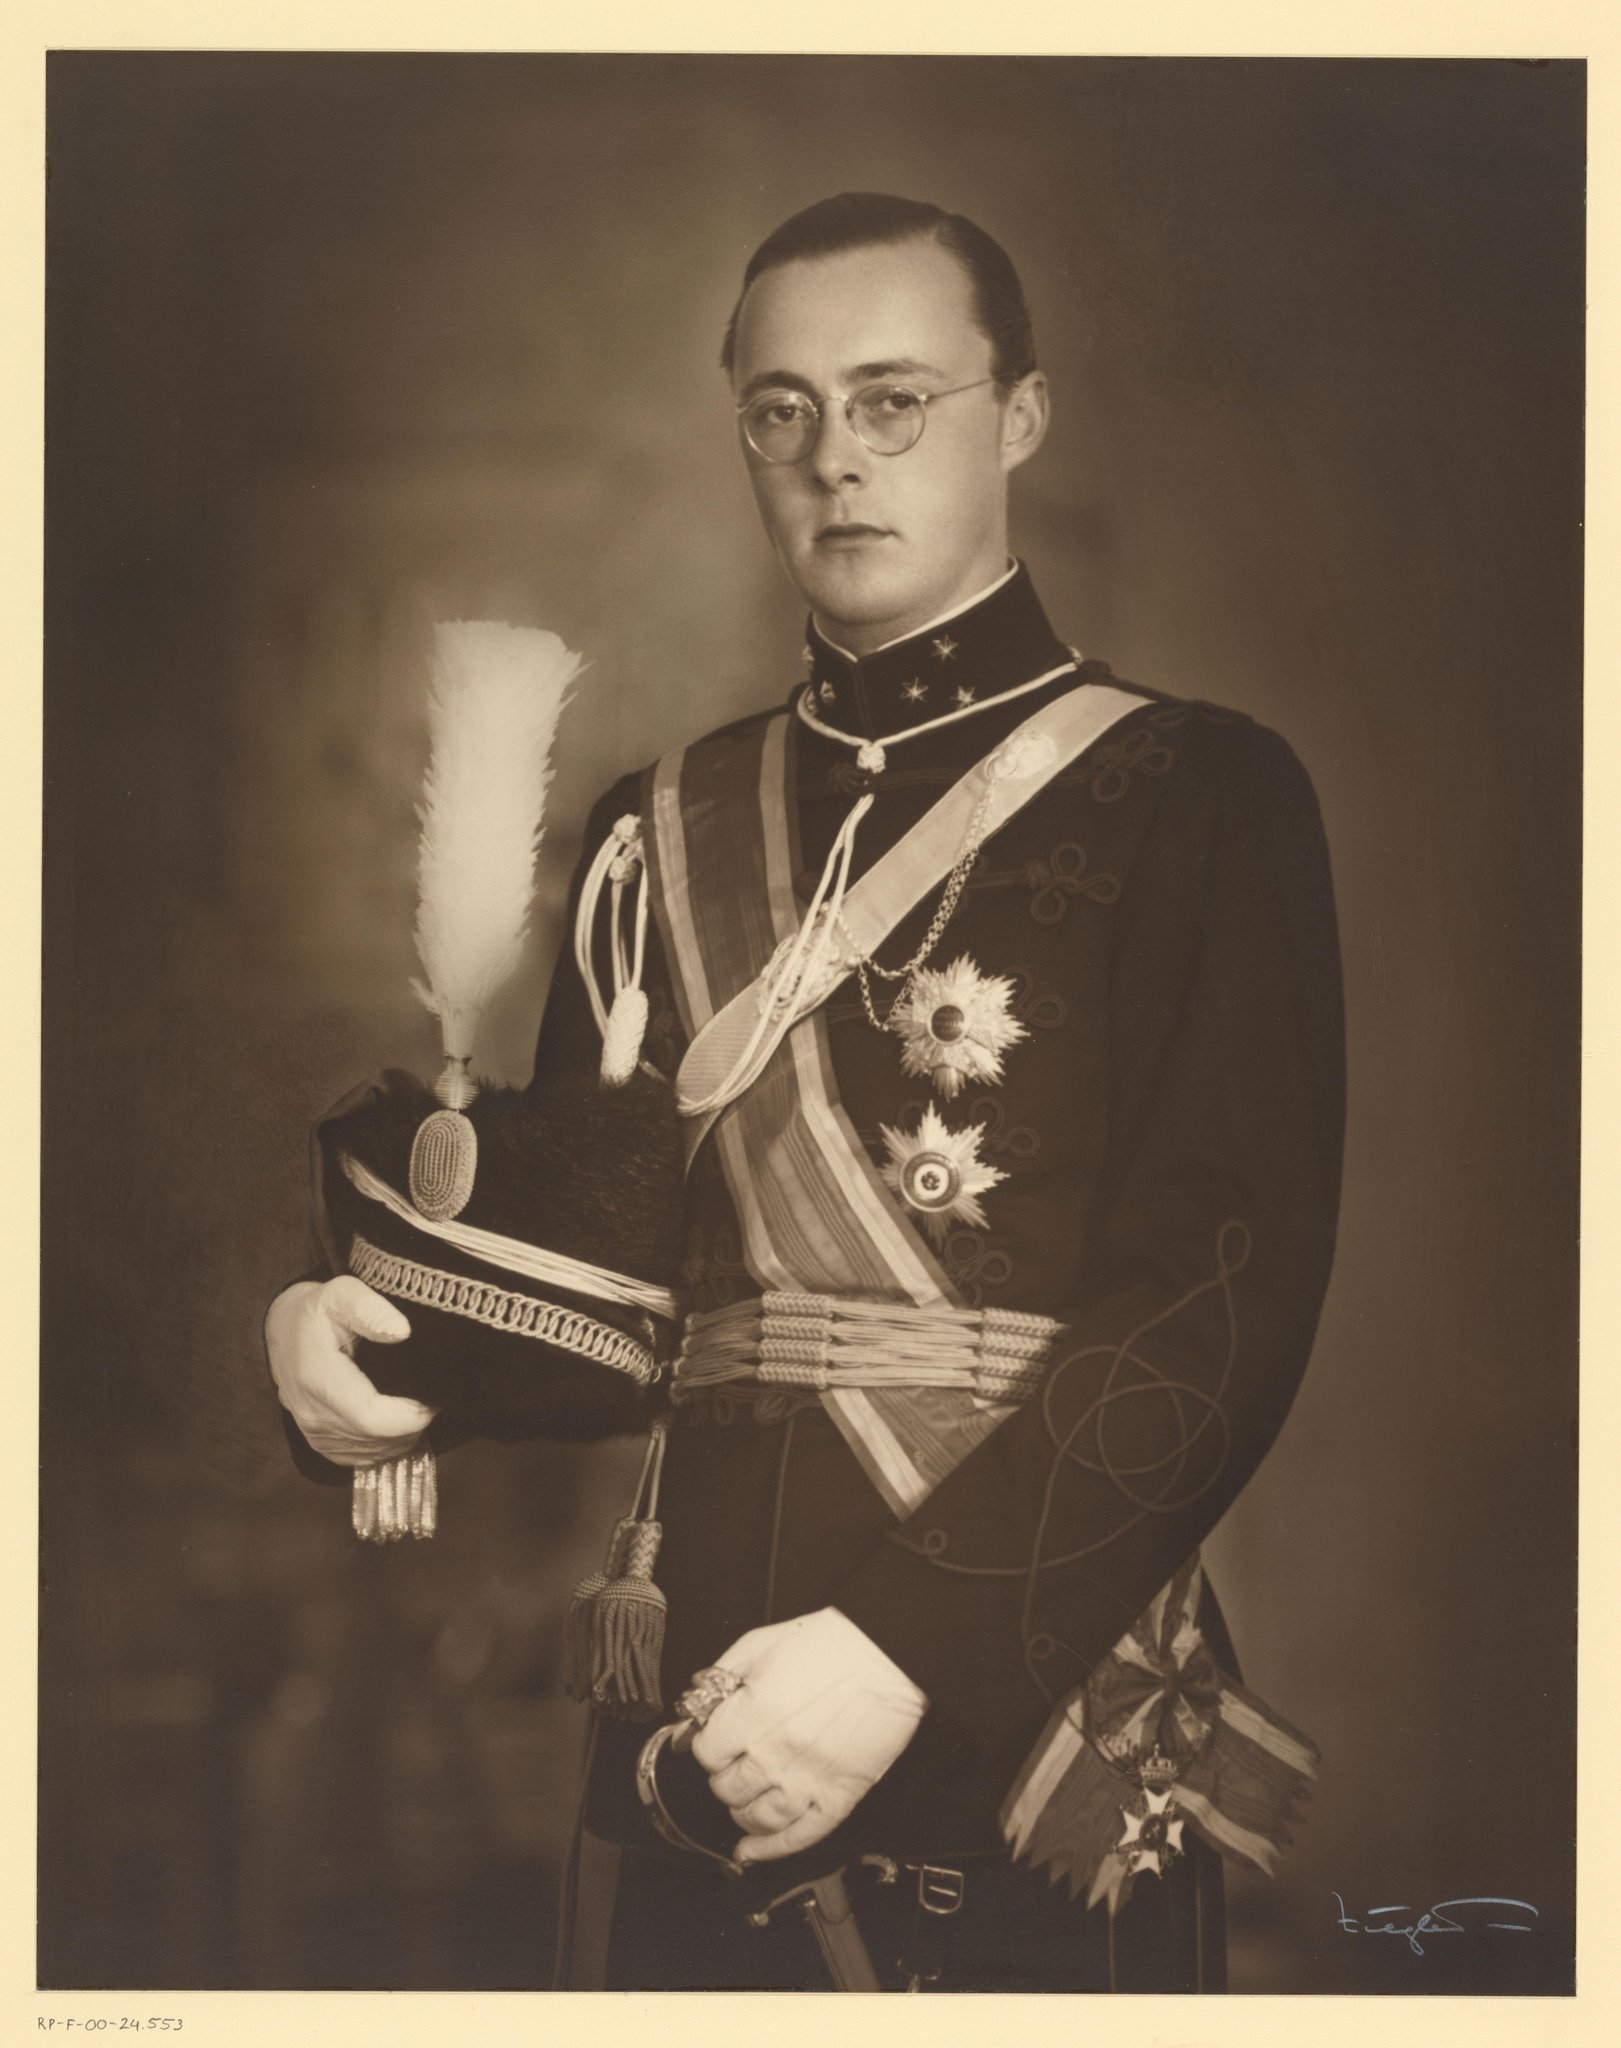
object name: photograph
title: Portret van prins Bernhard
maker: franz ziegler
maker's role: fotograaf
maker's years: 1893-1939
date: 1937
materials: paper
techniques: gelatin silver print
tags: utrecht, bernhard (prins der nederlanden), historical persons, (military) uniforms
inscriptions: signature: ‘Ziegler’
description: Portret van prins Bernhard, kniestuk, staande in uniform als cavalerieofficier in ceremonieel tenue. Militair hoofddeksel (kolbak?) in de rechterhand, de linkerhand op het gevest van de sabel. Ter gelegenheid van of kort na zijn huwelijk met Juliana op 7 januari 1937.